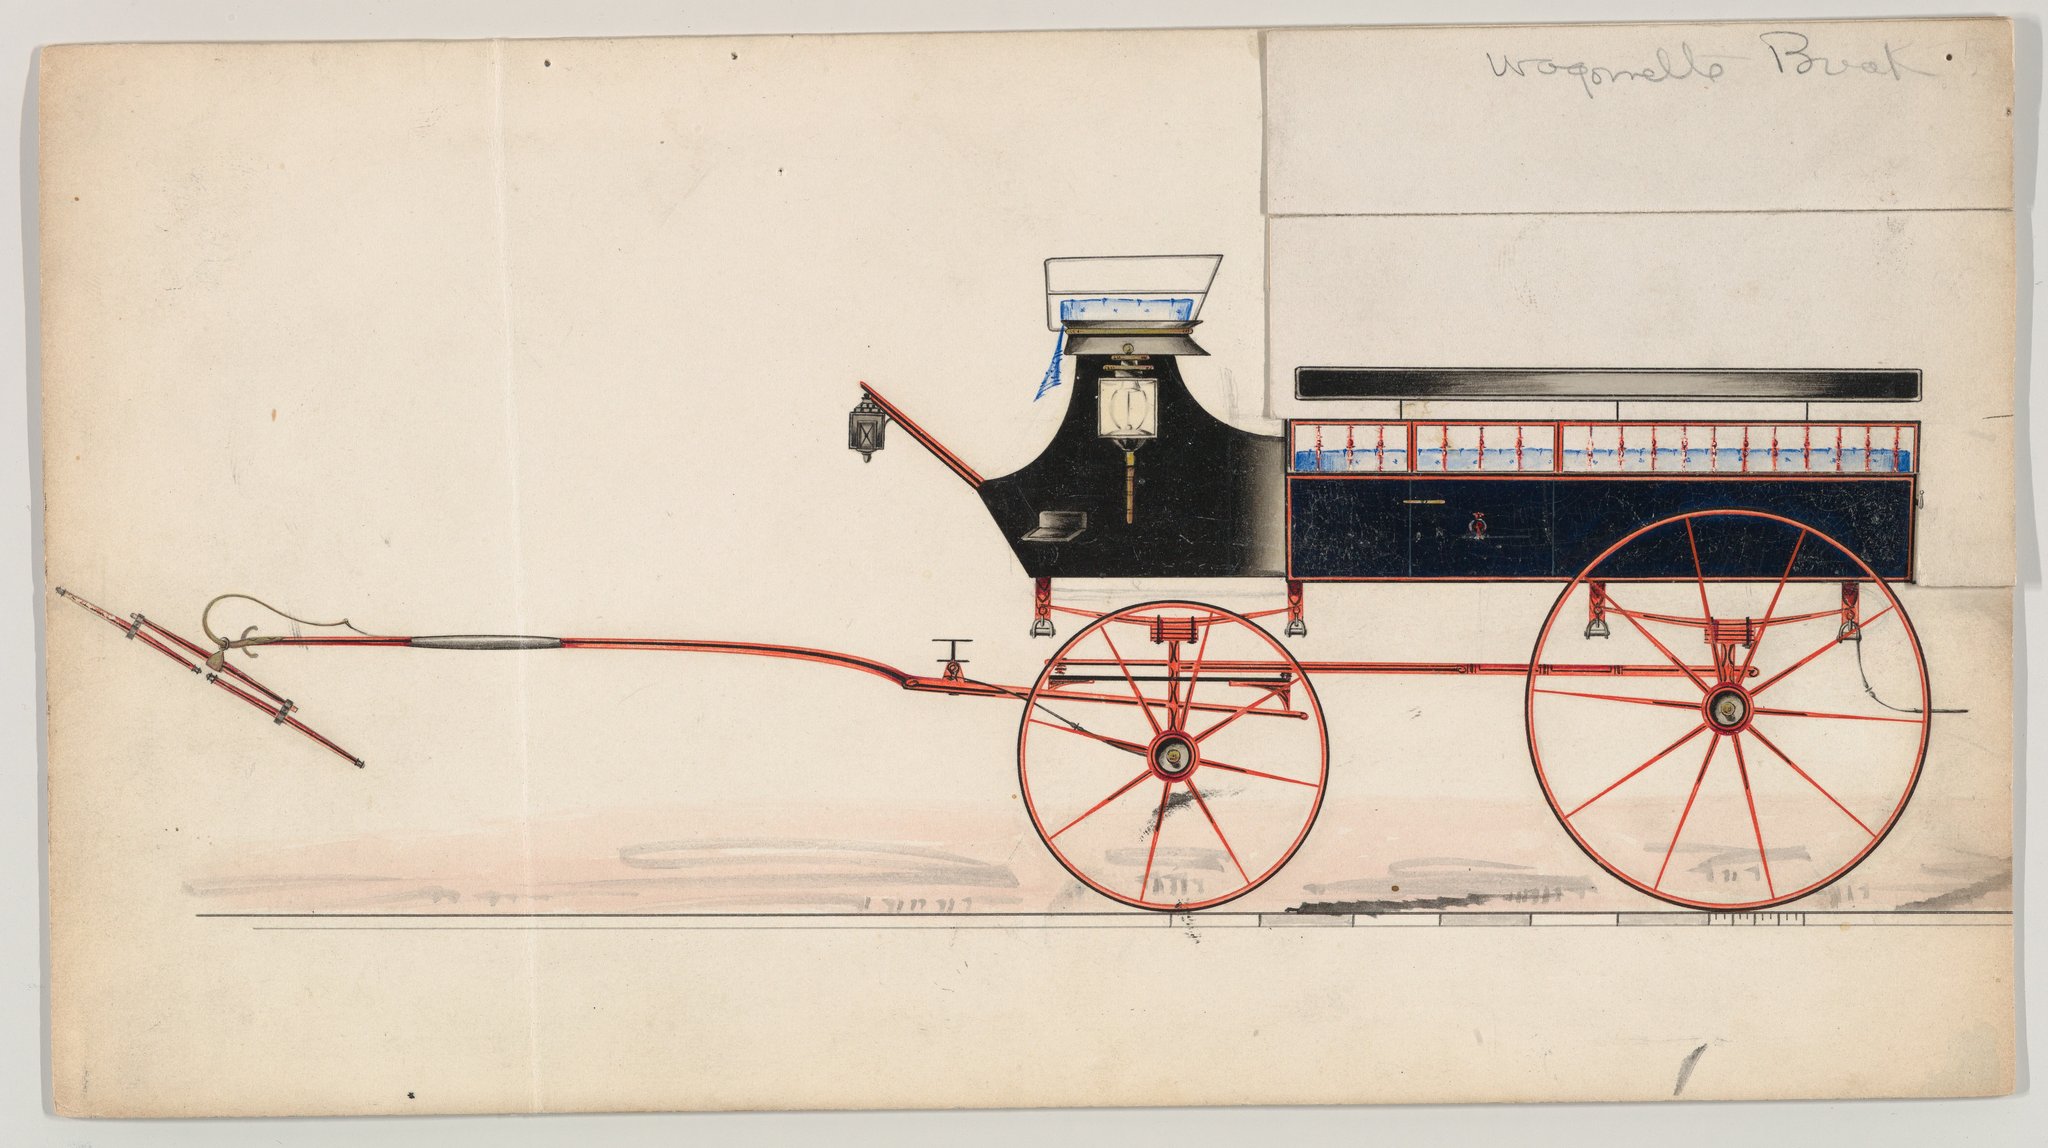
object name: drawing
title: Wagonette Break (no number)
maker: brewster & co.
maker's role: manufacturer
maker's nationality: american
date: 1850-1870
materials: gouache, gum arabic, ink, watercolor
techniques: pen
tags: carriages